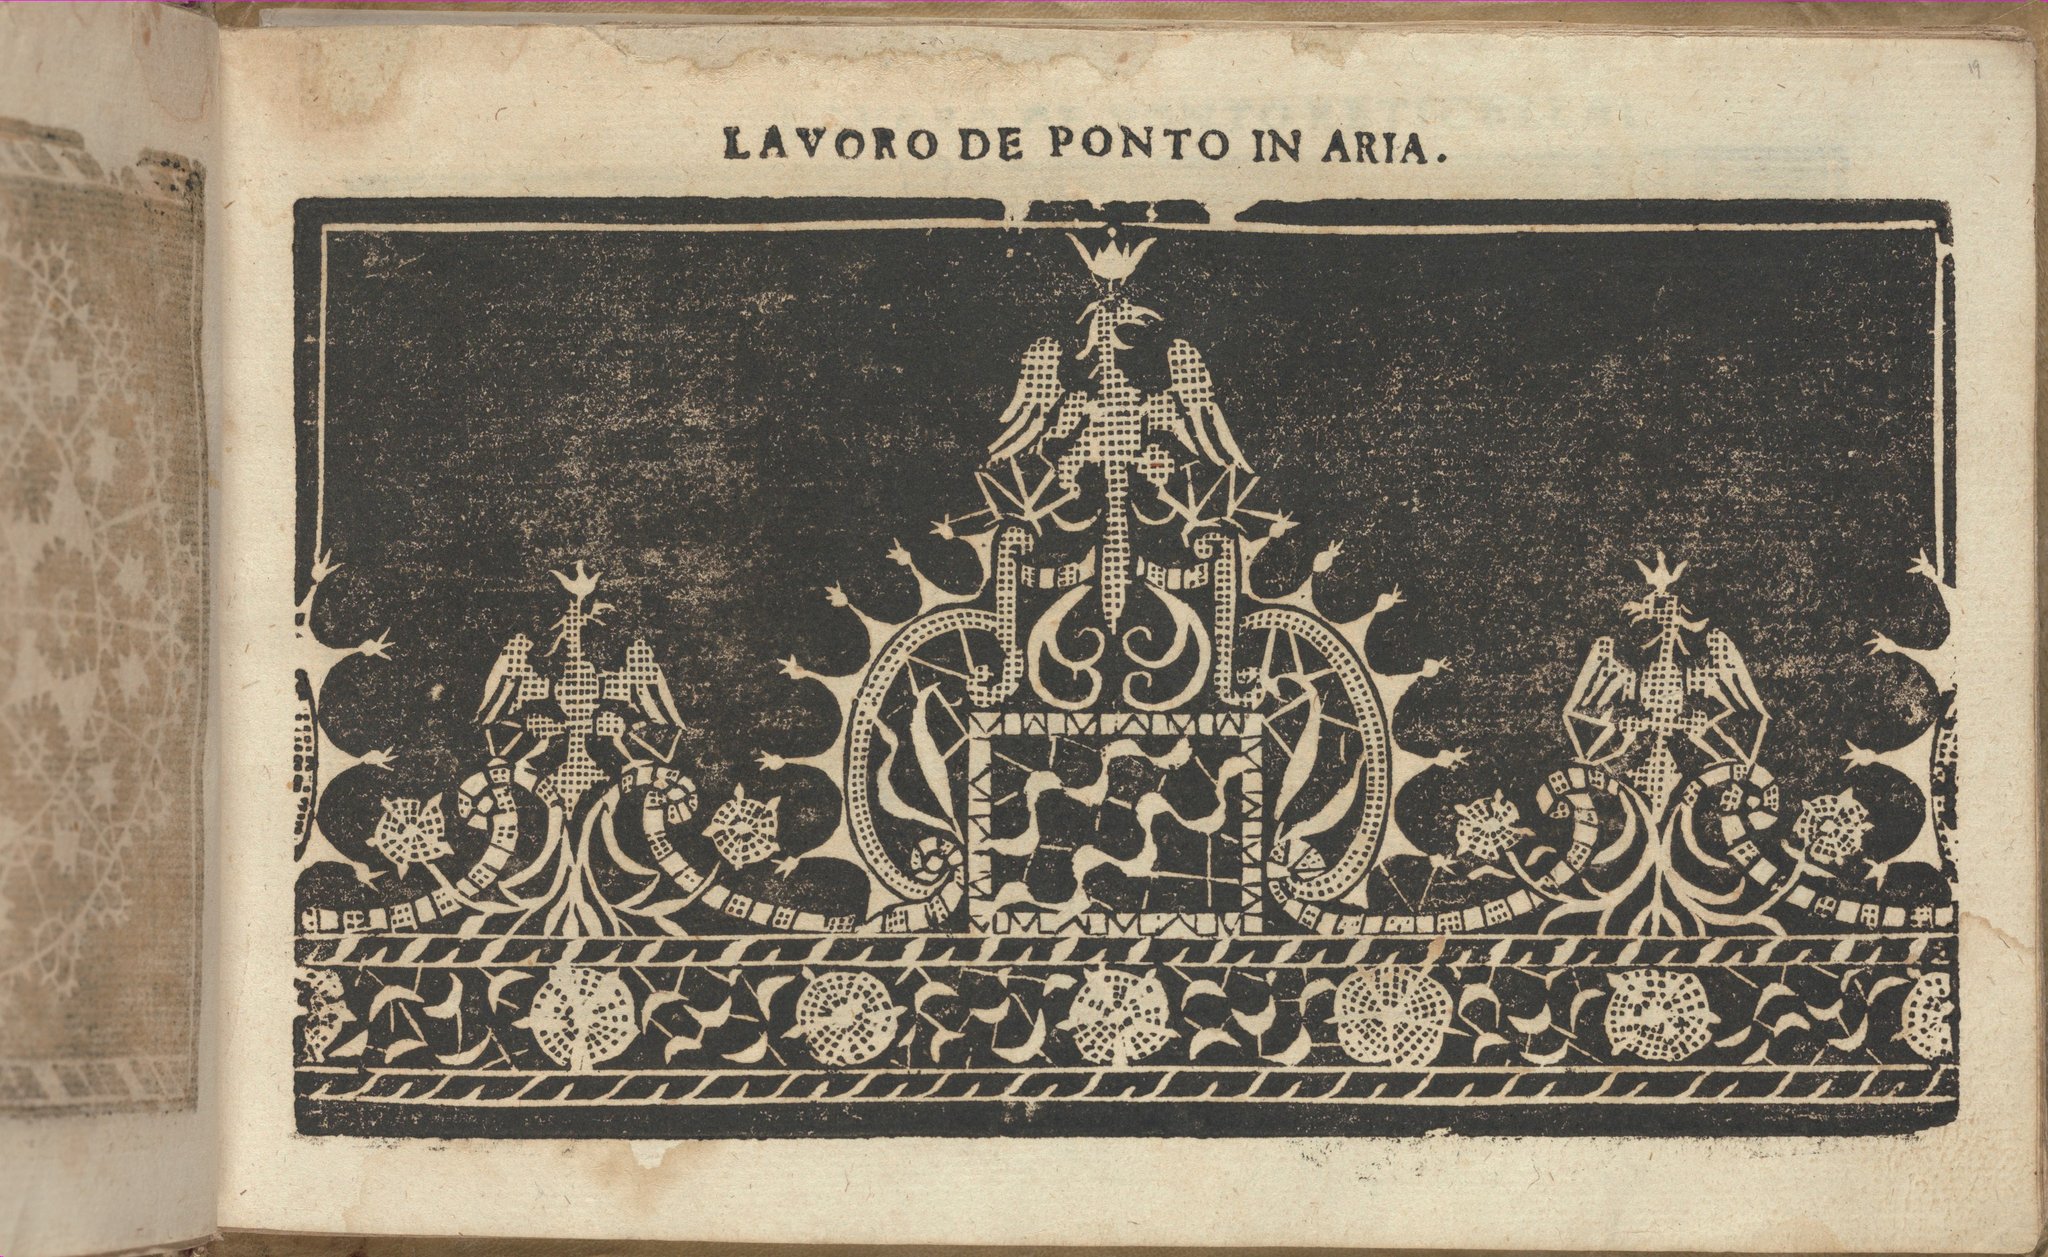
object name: book print ornament architecture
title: Studio delle virtuose Dame, page 19 (recto)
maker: isabella catanea parasole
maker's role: designer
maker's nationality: italian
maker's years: 1565-1625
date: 1597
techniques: woodcut